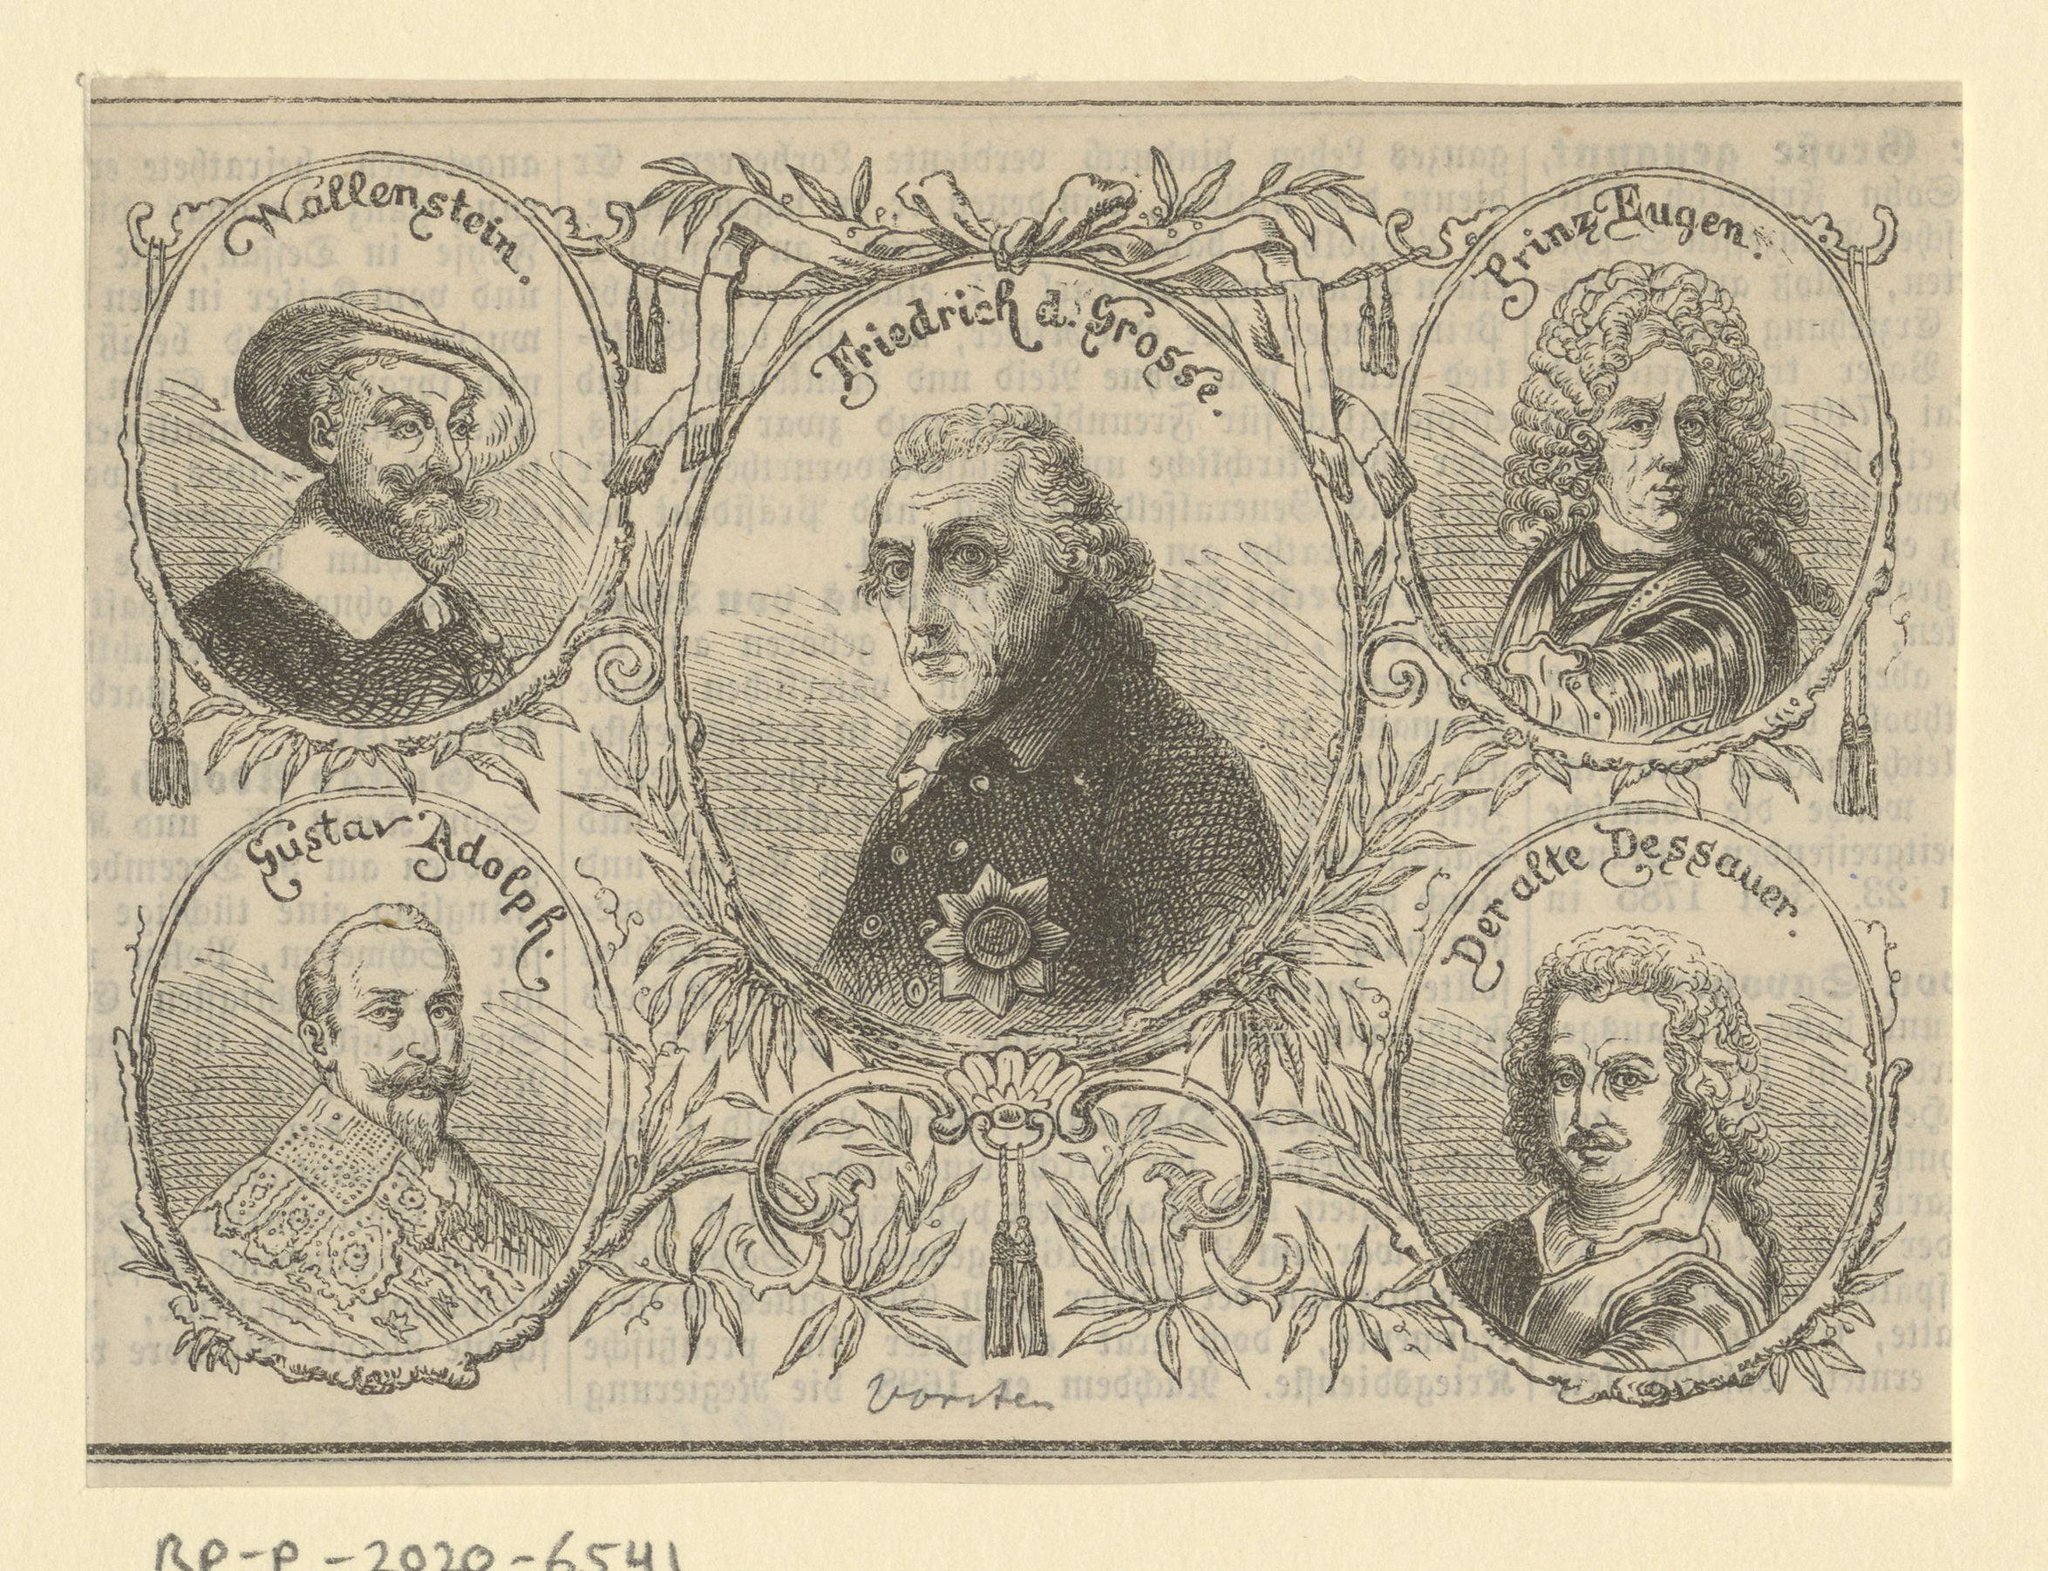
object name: print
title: Portret van Albrecht von Wallenstein, Gustaaf II Adolf van Zweden, Frederik de Grote, Eugenius van Savoye en Leopold I van Anhalt-Dessau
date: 1867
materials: paper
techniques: letterpress printing, engraving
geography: germany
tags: paris, vienna, eugenius van savoye, berlin, frederick ii (king of prussia), ornament ~ medallion, historical persons, king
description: Vijf portretten in medaillon, met centraal Frederik de Grote.